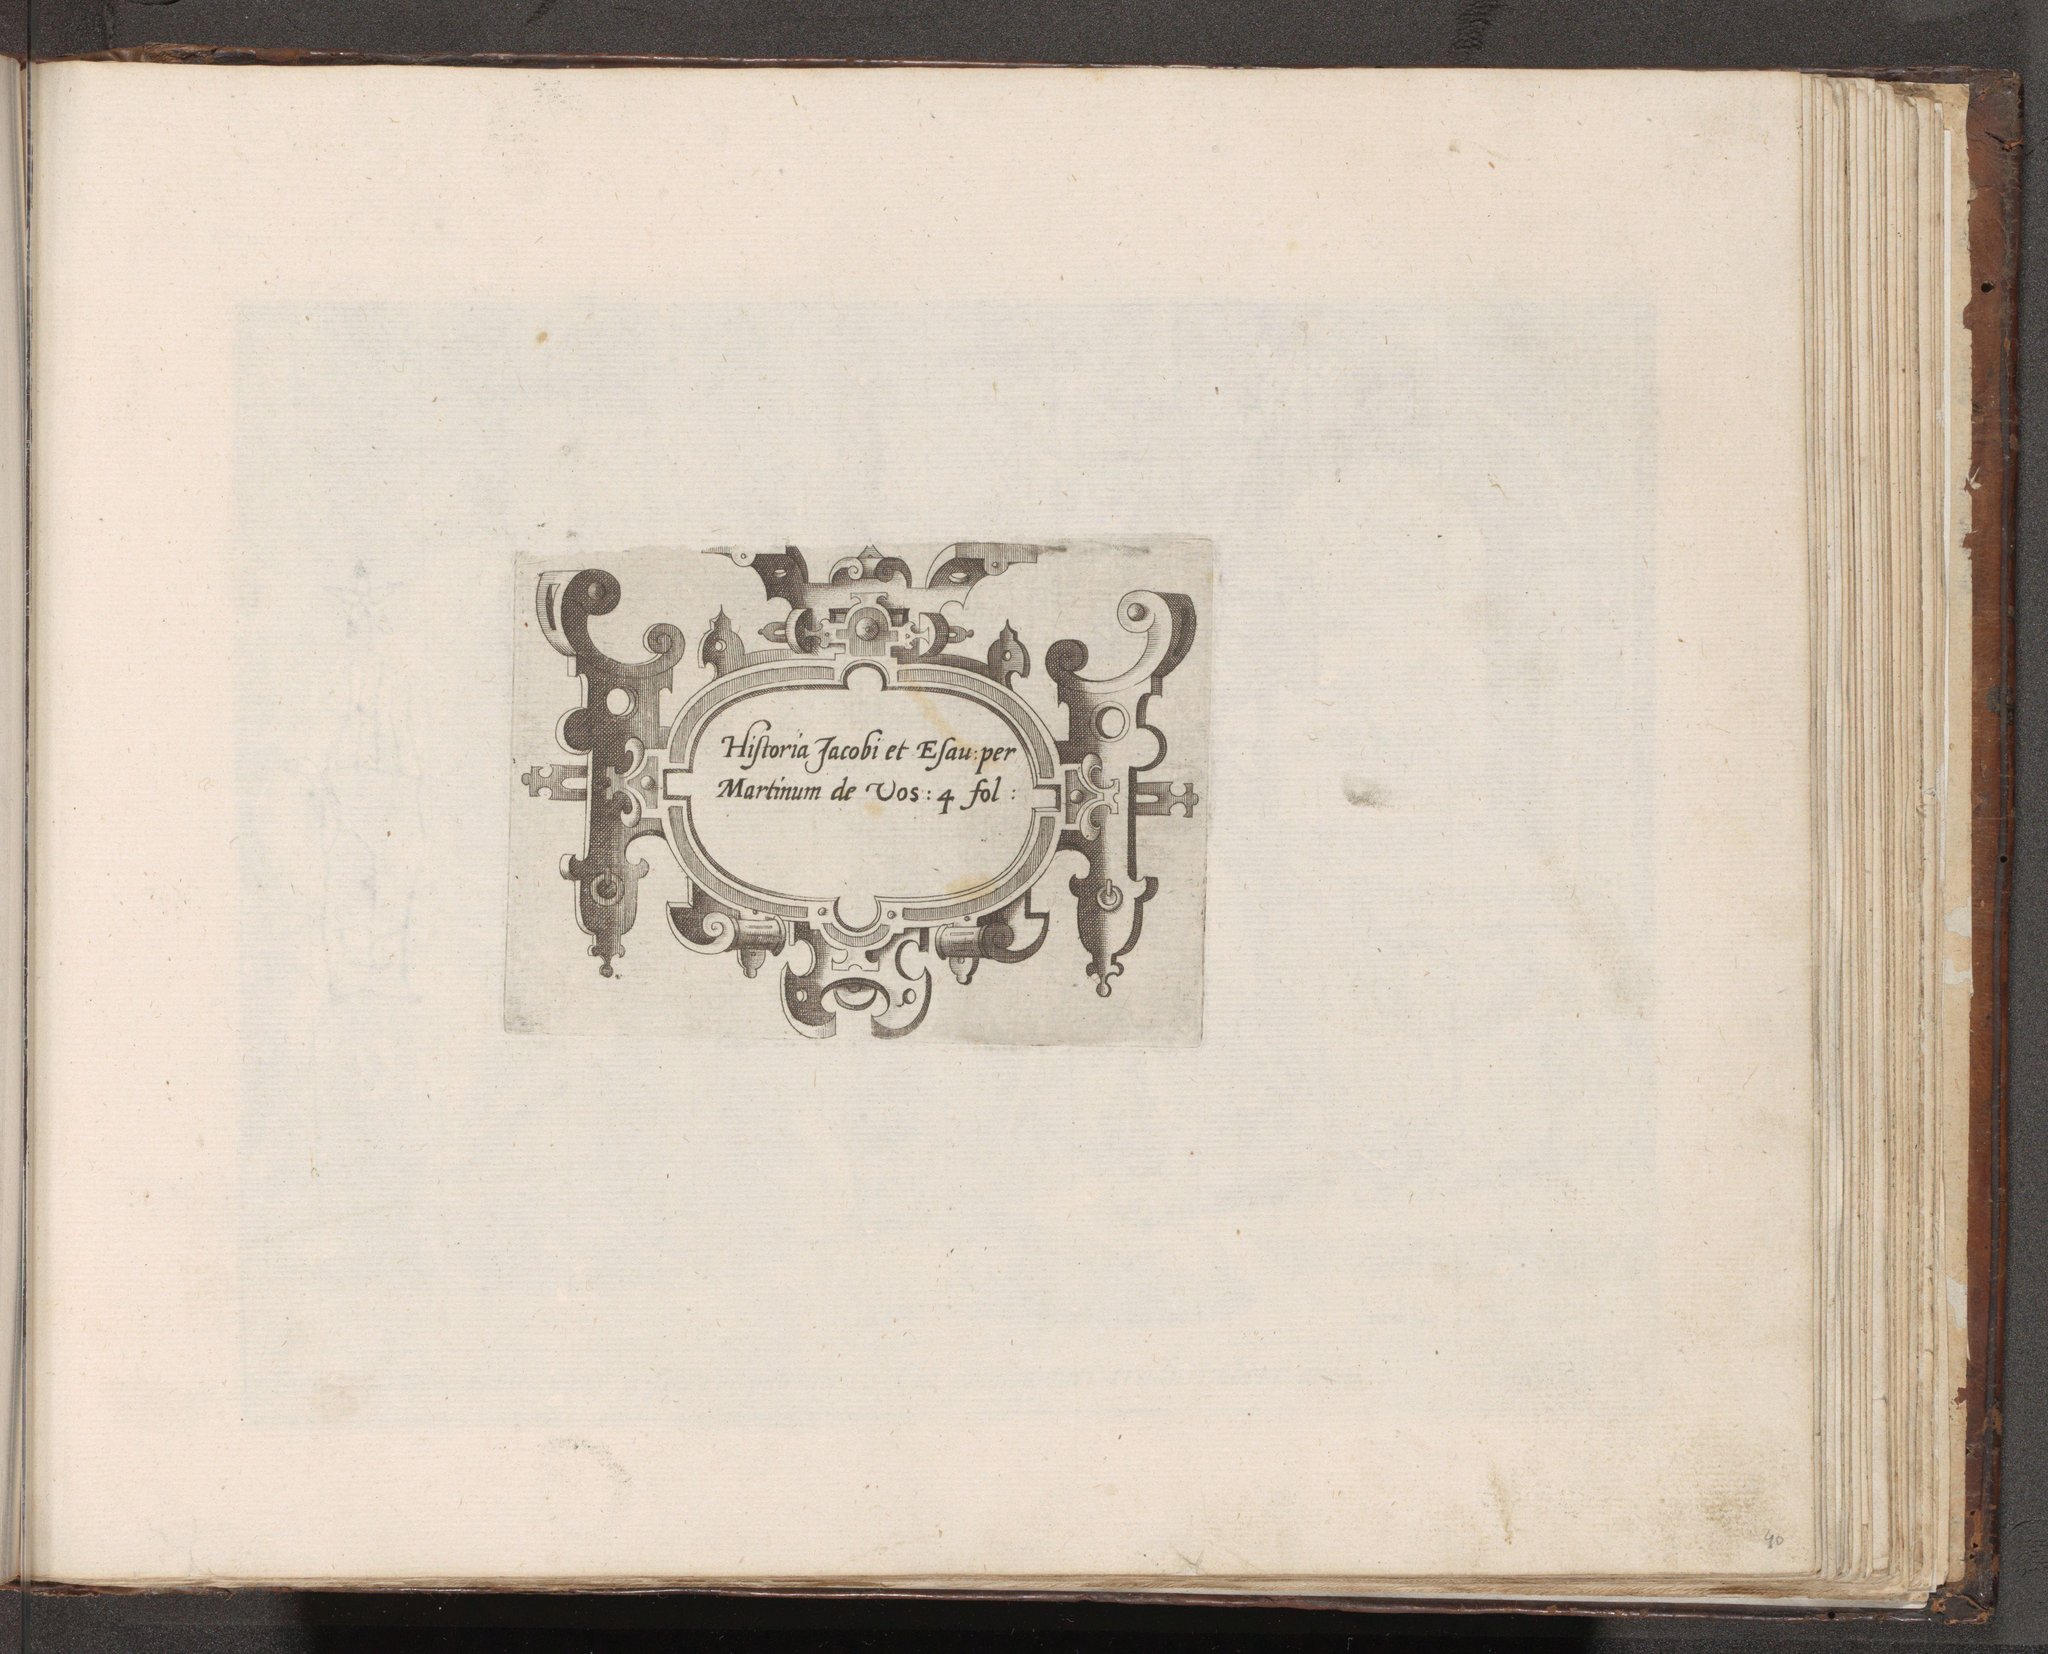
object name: album leaf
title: Thesaurus sacrarum historiaru[m] veteris testame[n]ti, elega[n]tissimis imaginibus expressu[m] excelle[n]tissimoru[m] in hac arte viroru[m] opera: nu[n]c primu[m] in luce[m] editus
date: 1579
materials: paper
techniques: engraving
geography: antwerp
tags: scrollwork, strapwork ~ ornament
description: Titel in cartouche met rolwerk. Titelprent voor een serie prenten over de geschiedenis van Jakob en Esau. Prent maakt deel uit van een album.